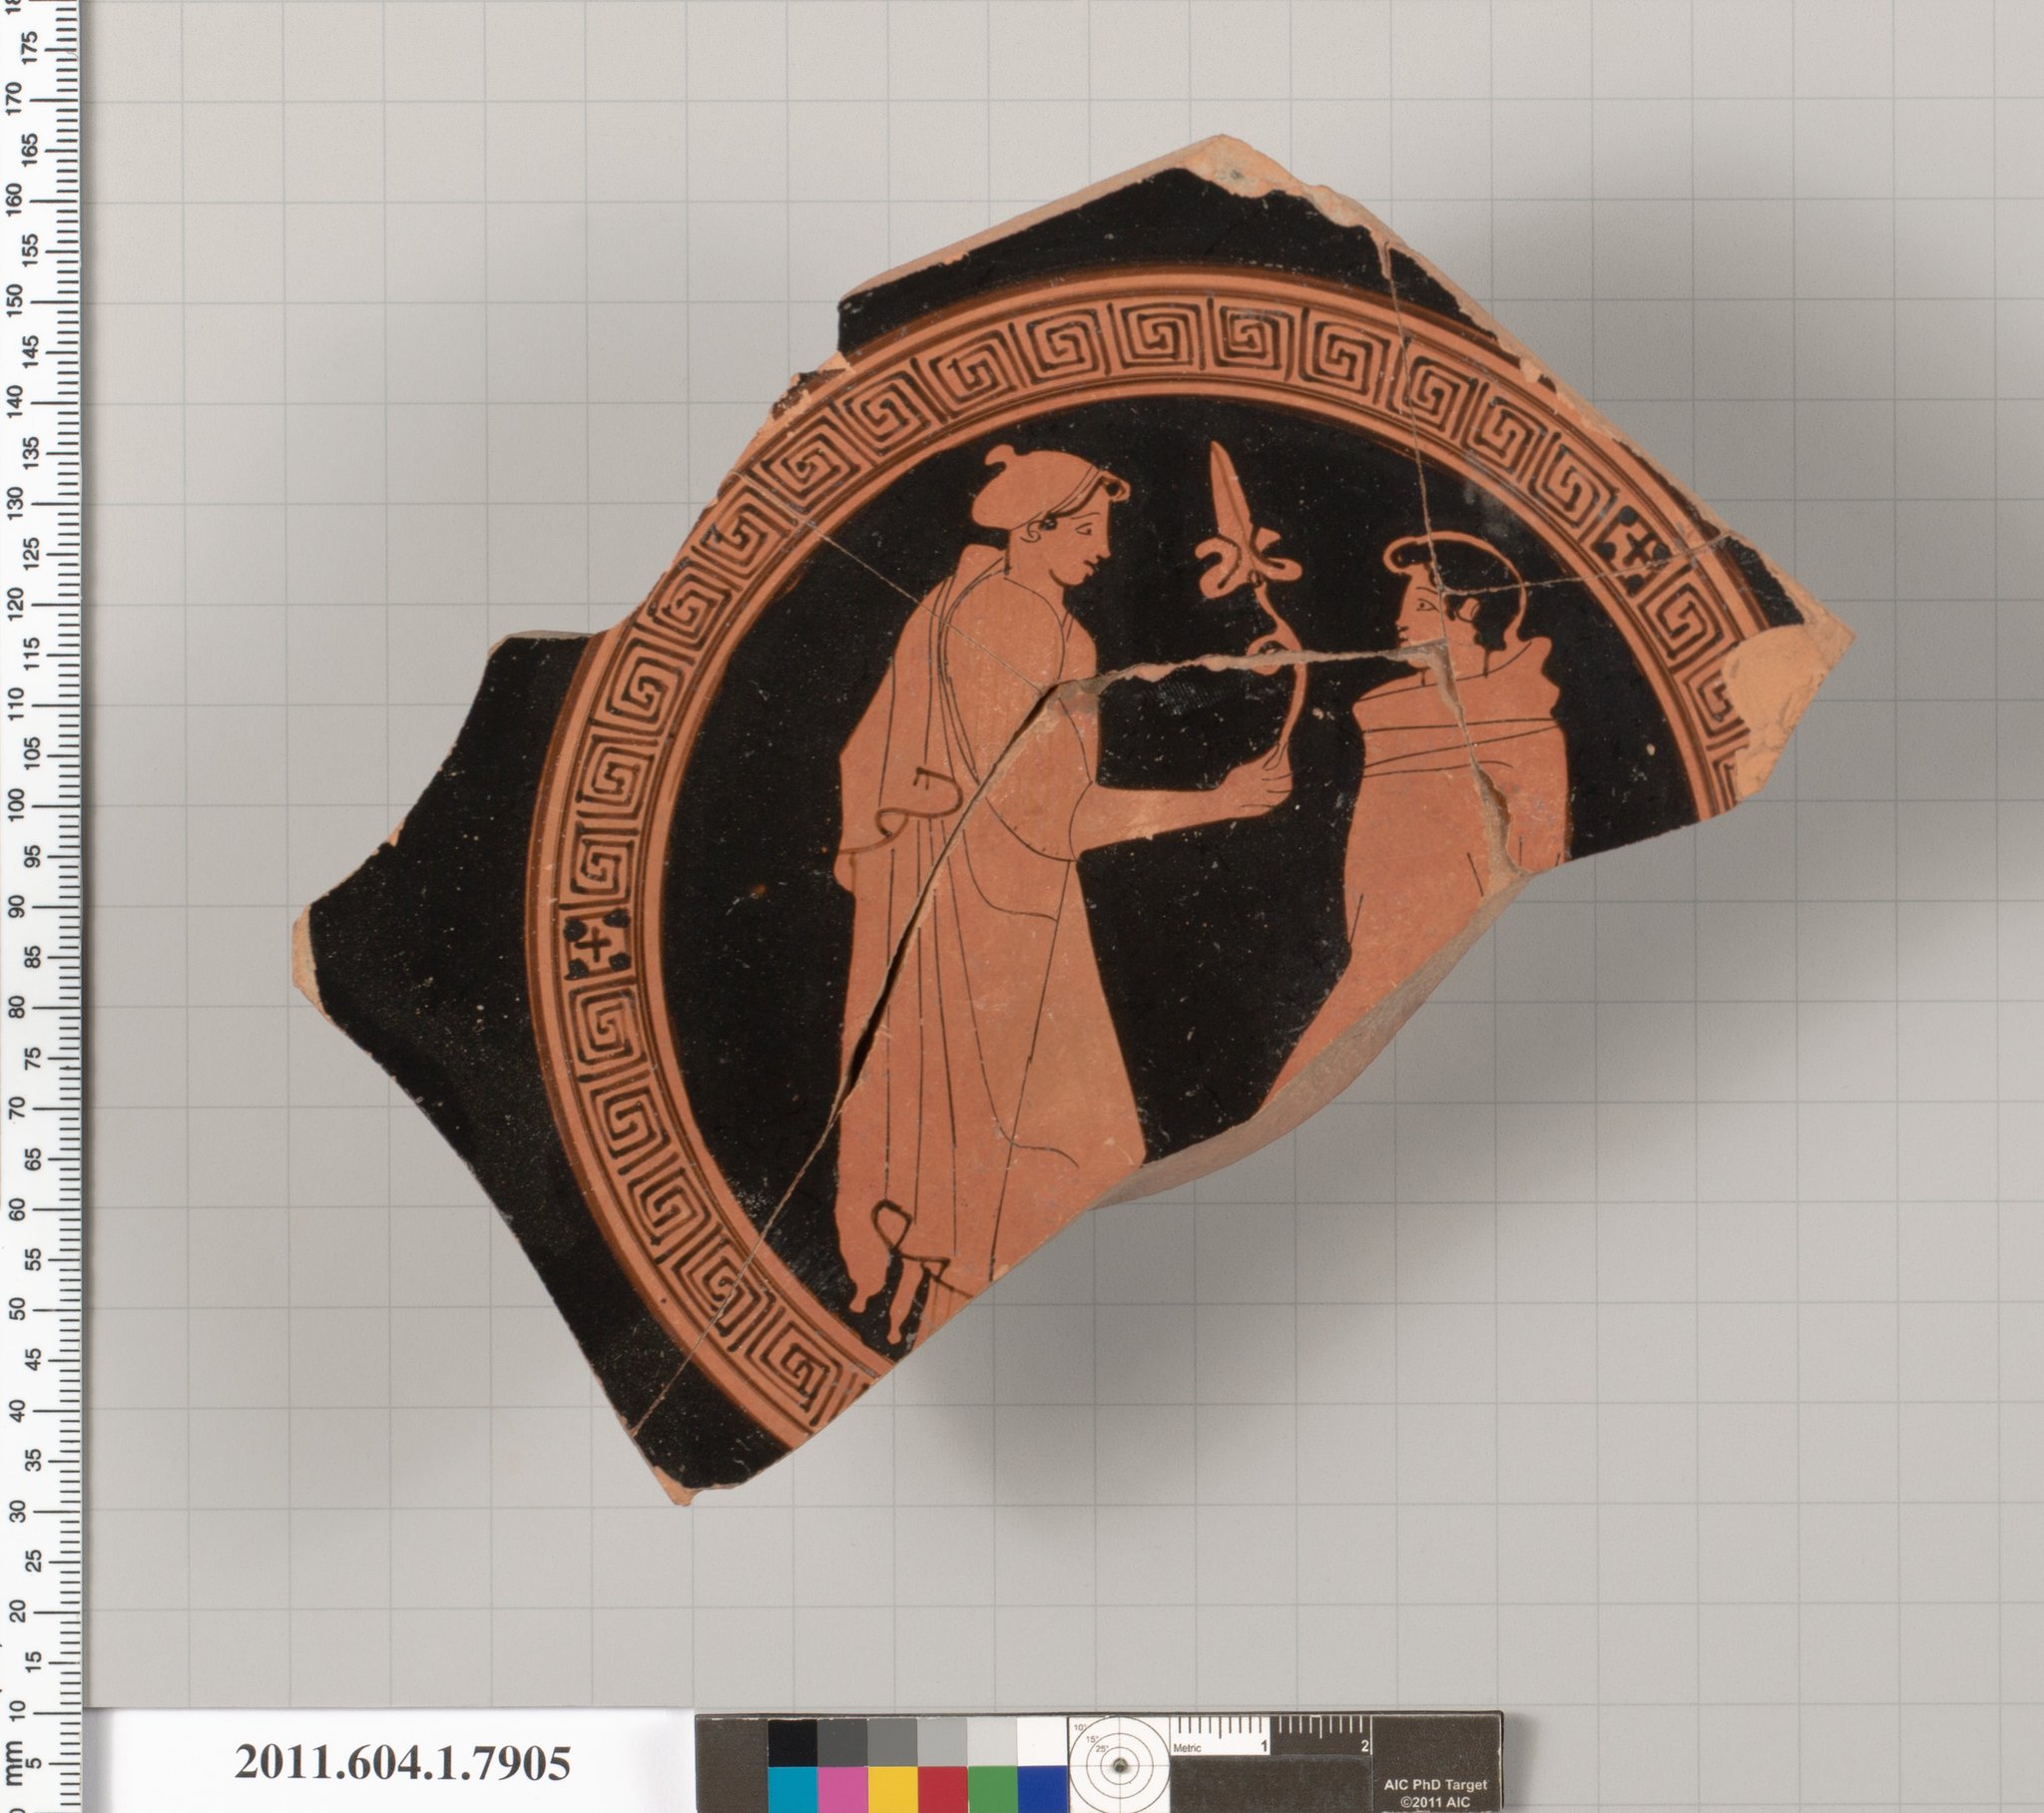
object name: kylix fragment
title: Terracotta fragment of a kylix (drinking cup)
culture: greek, attic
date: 475-451 BCE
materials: terracotta